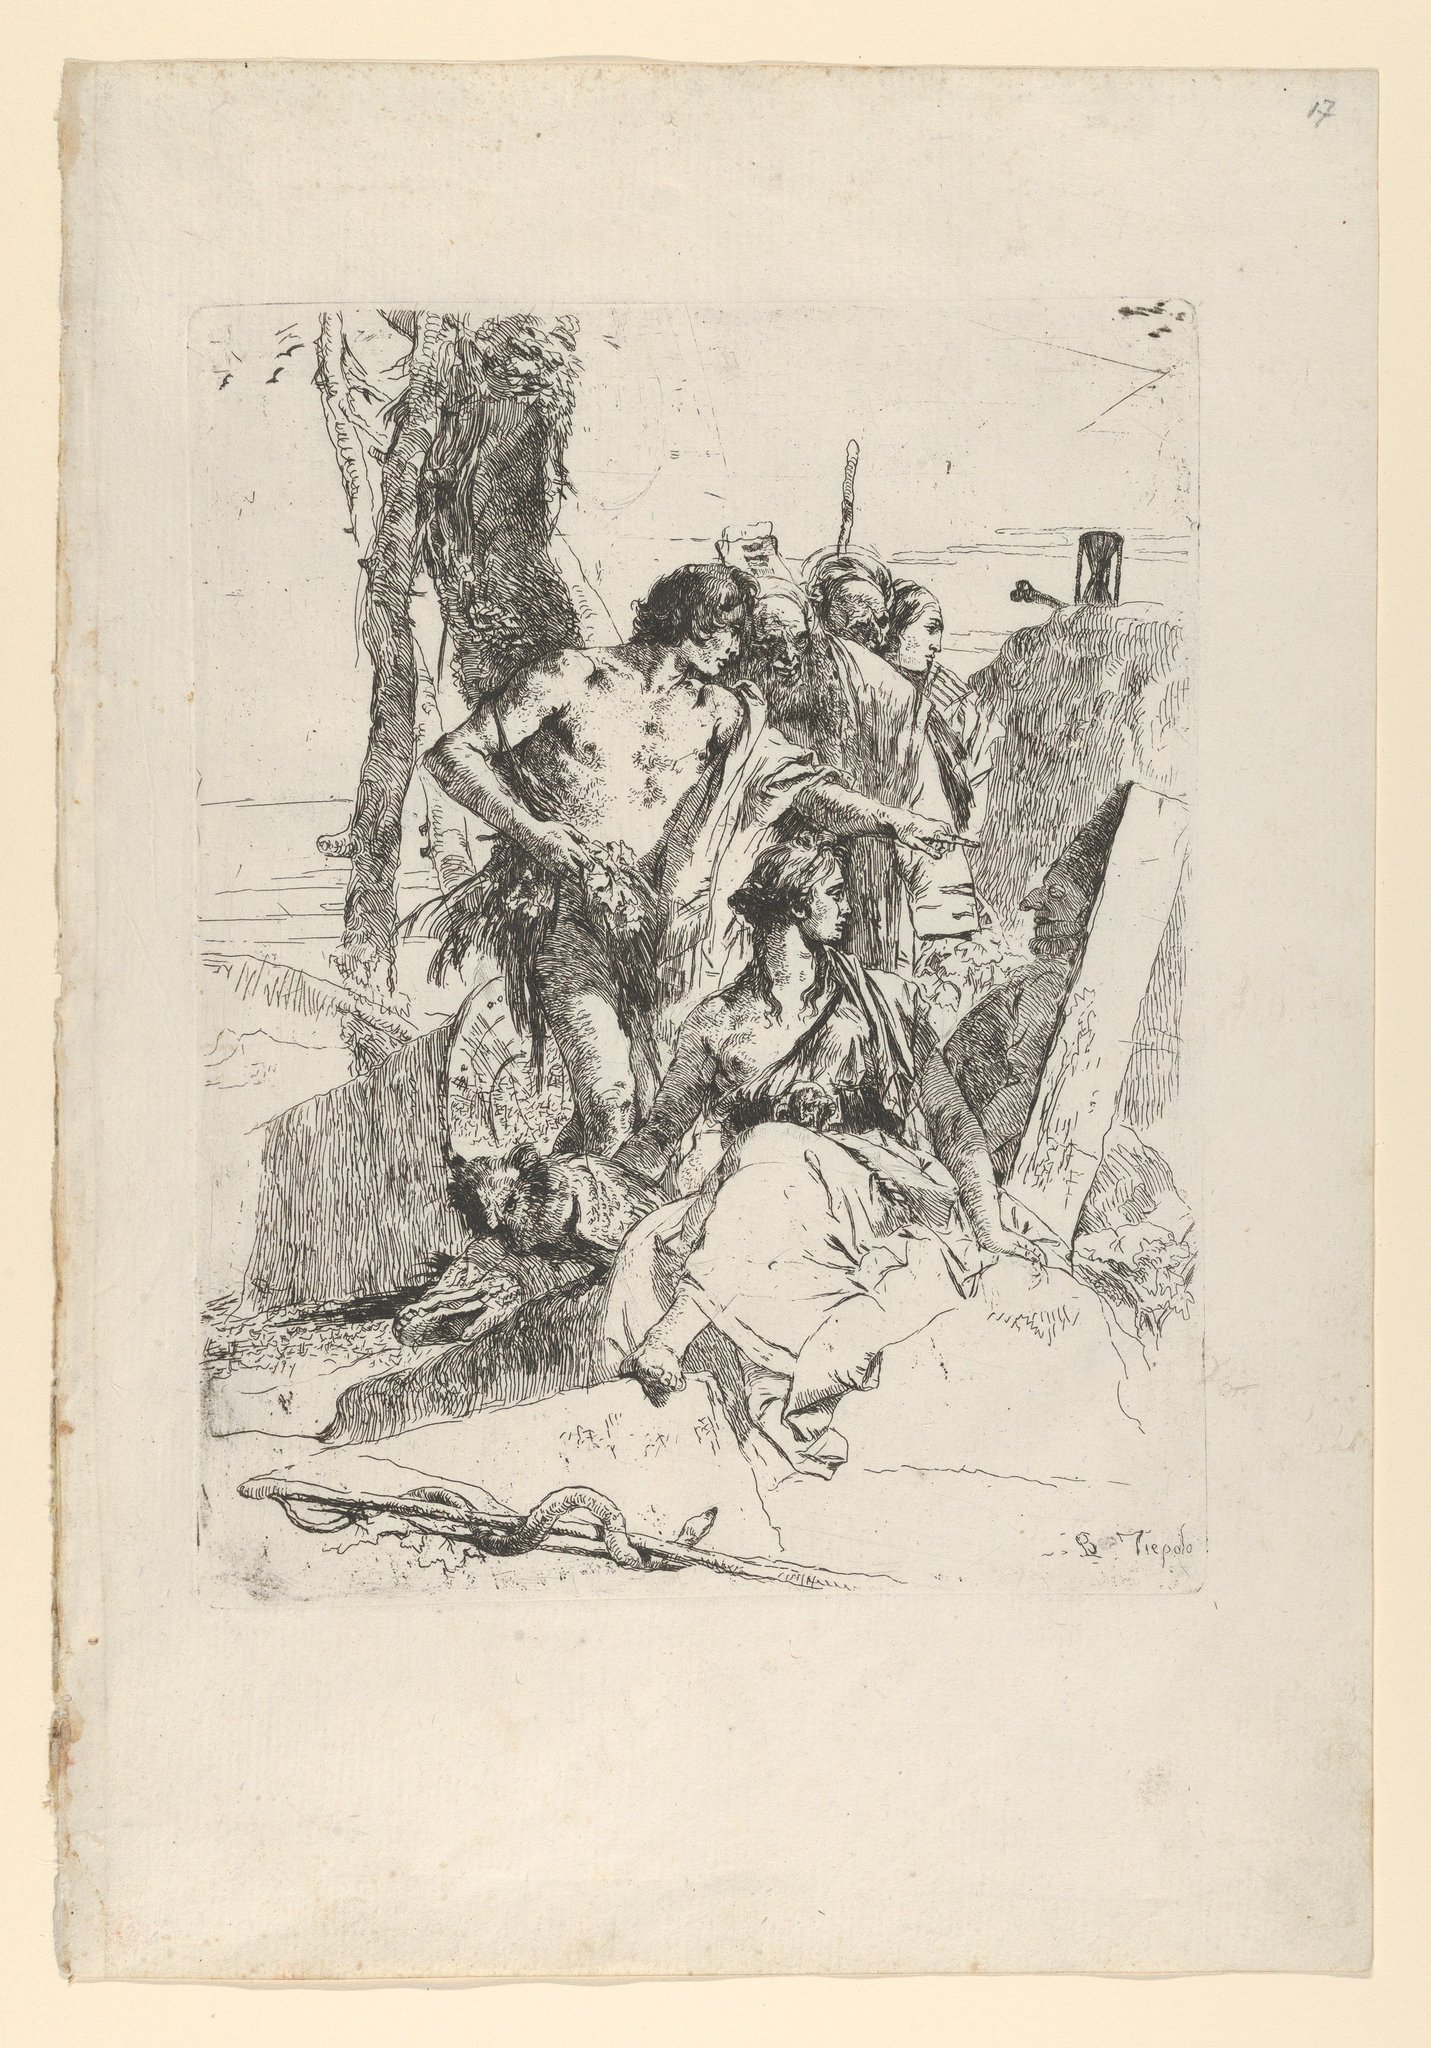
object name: print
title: The Discovery of the Tomb of Punchinello, from the Scherzi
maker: giovanni battista tiepolo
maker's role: artist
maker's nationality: italian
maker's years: 1696-1770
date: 1743-1750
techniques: etching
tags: men,women,snakes